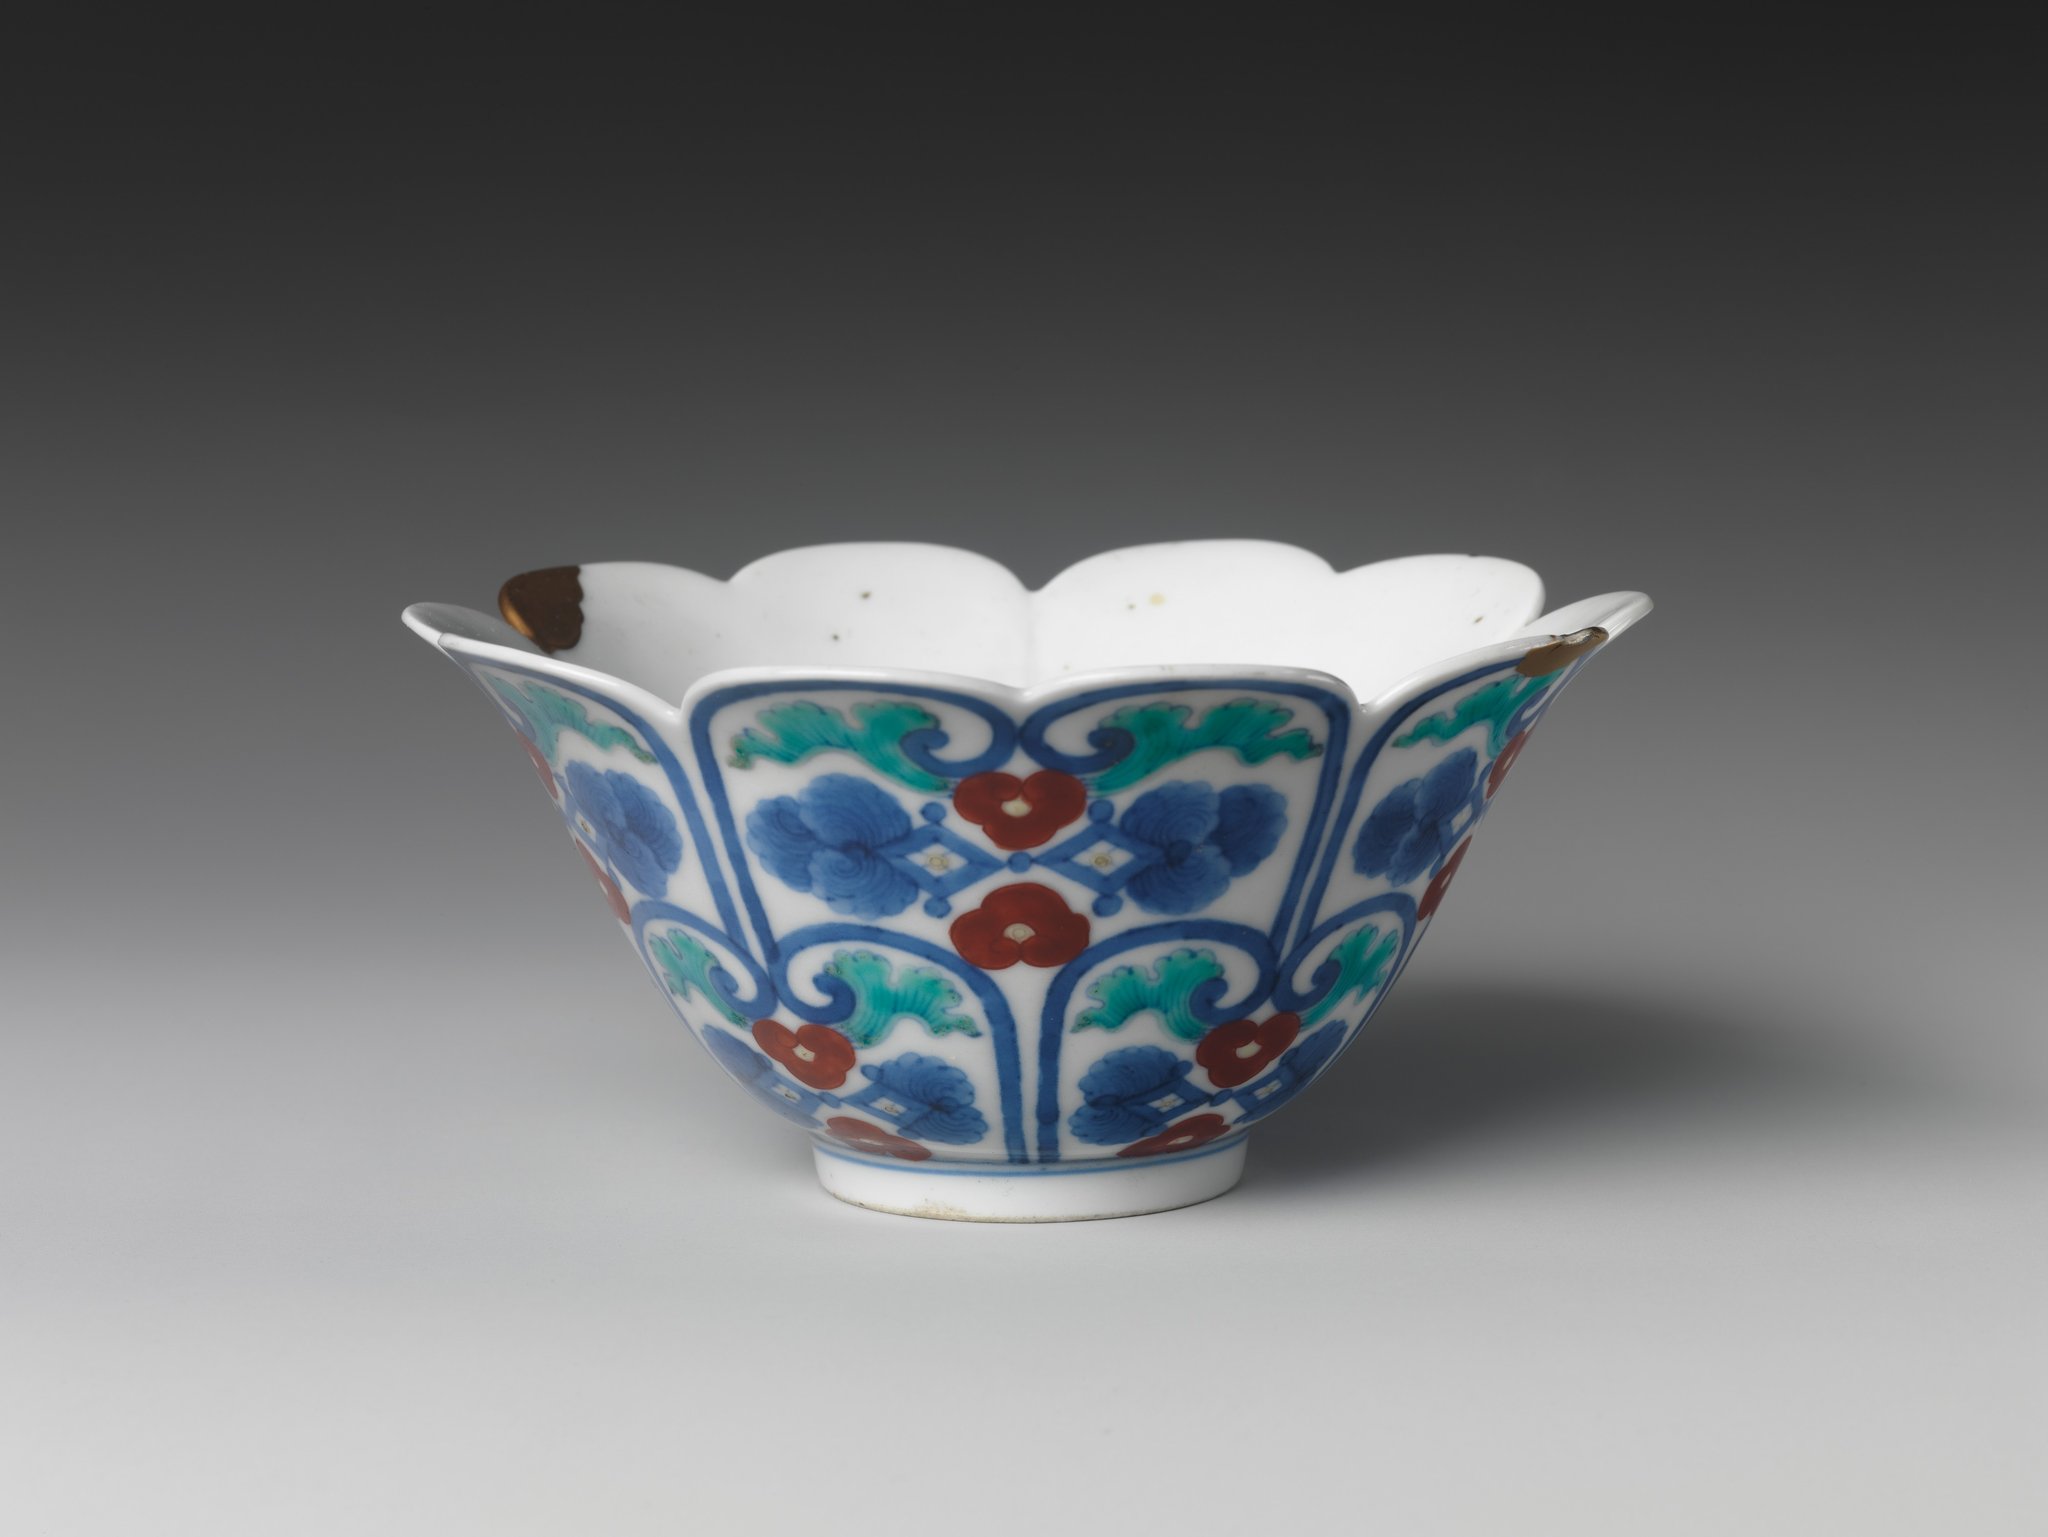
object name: cup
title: Cup in the Shape of a Blossom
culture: japanese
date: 1780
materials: enamel, porcelain